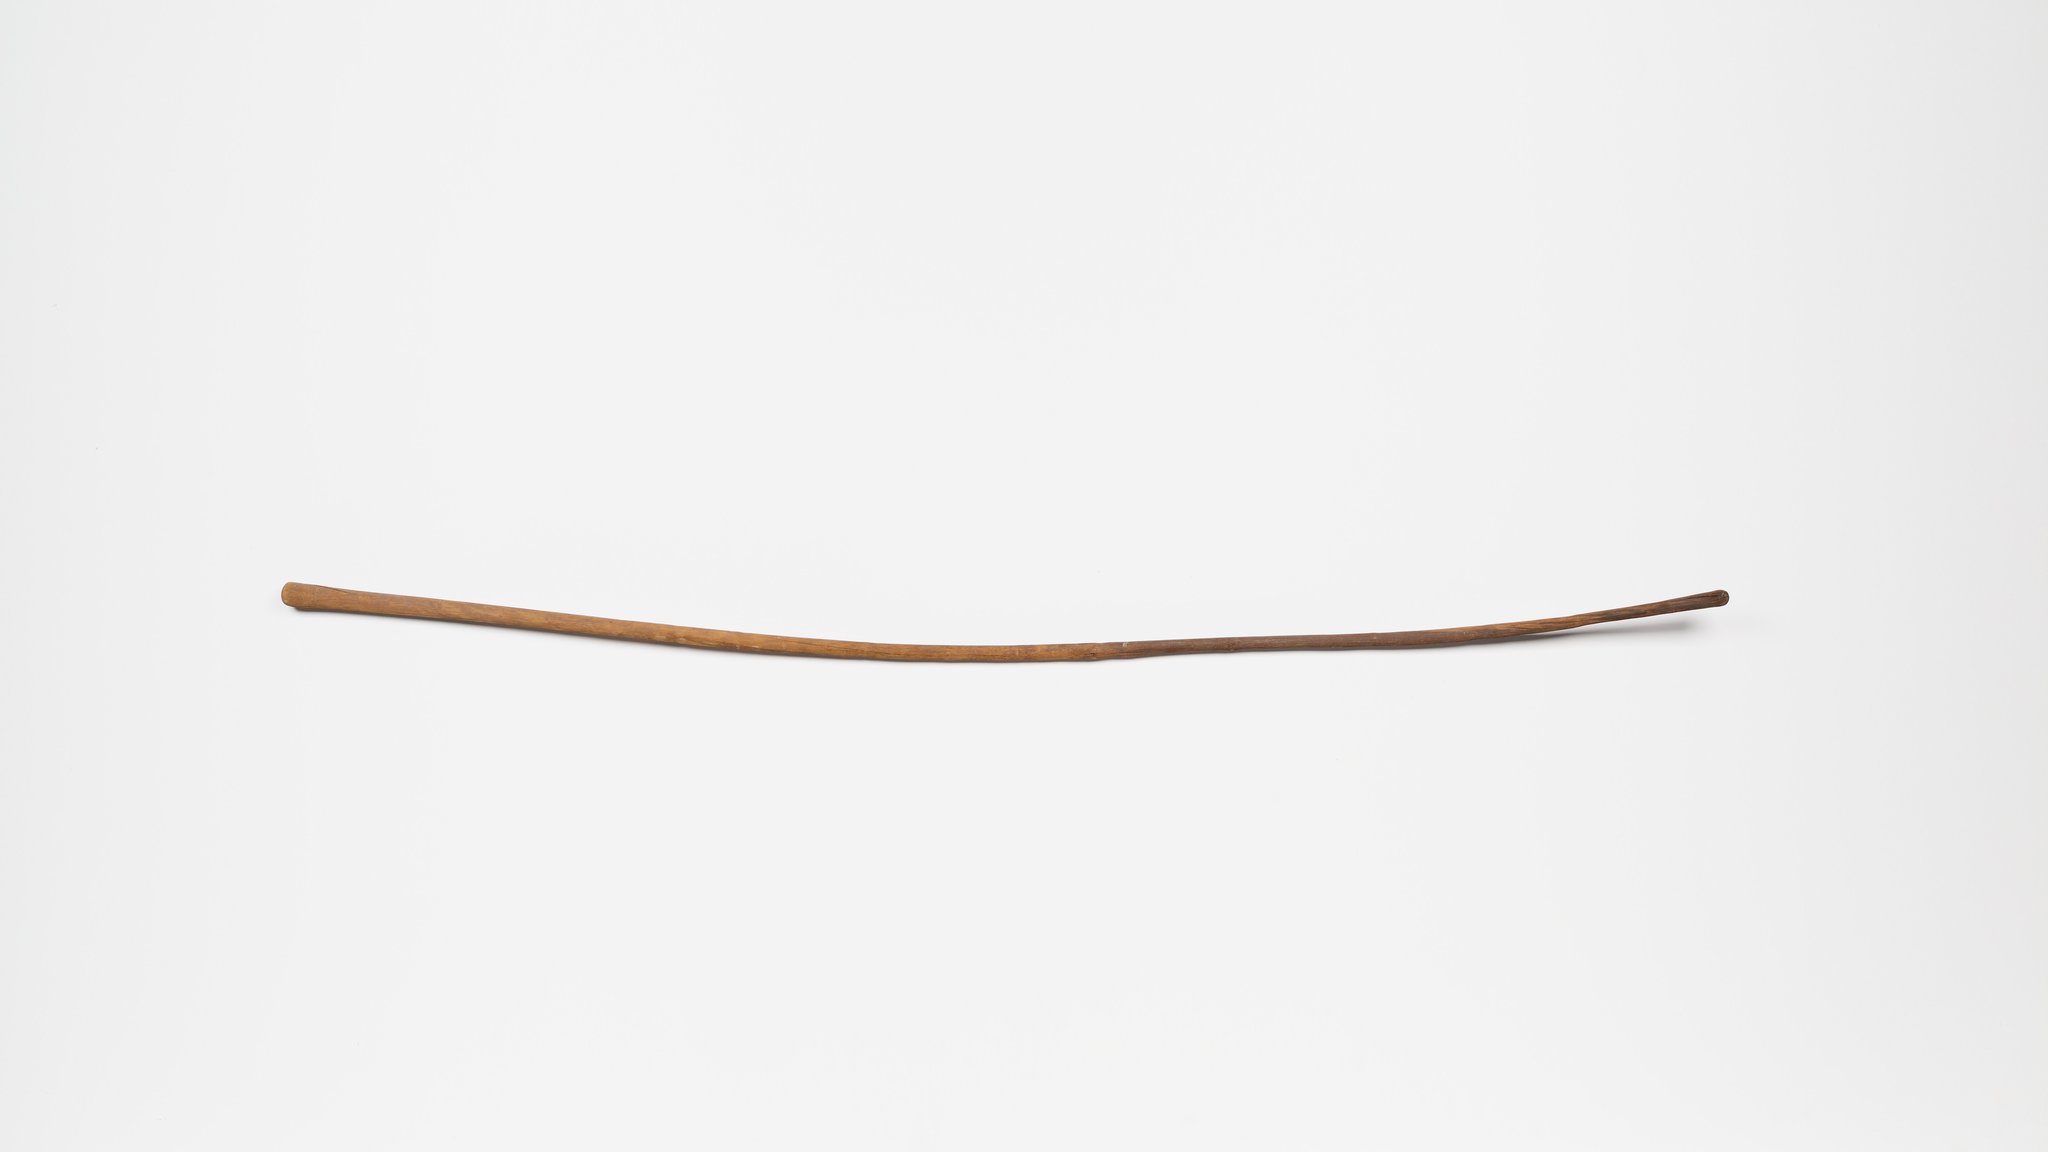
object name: staff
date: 1981-1802 BCE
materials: wood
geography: egypt